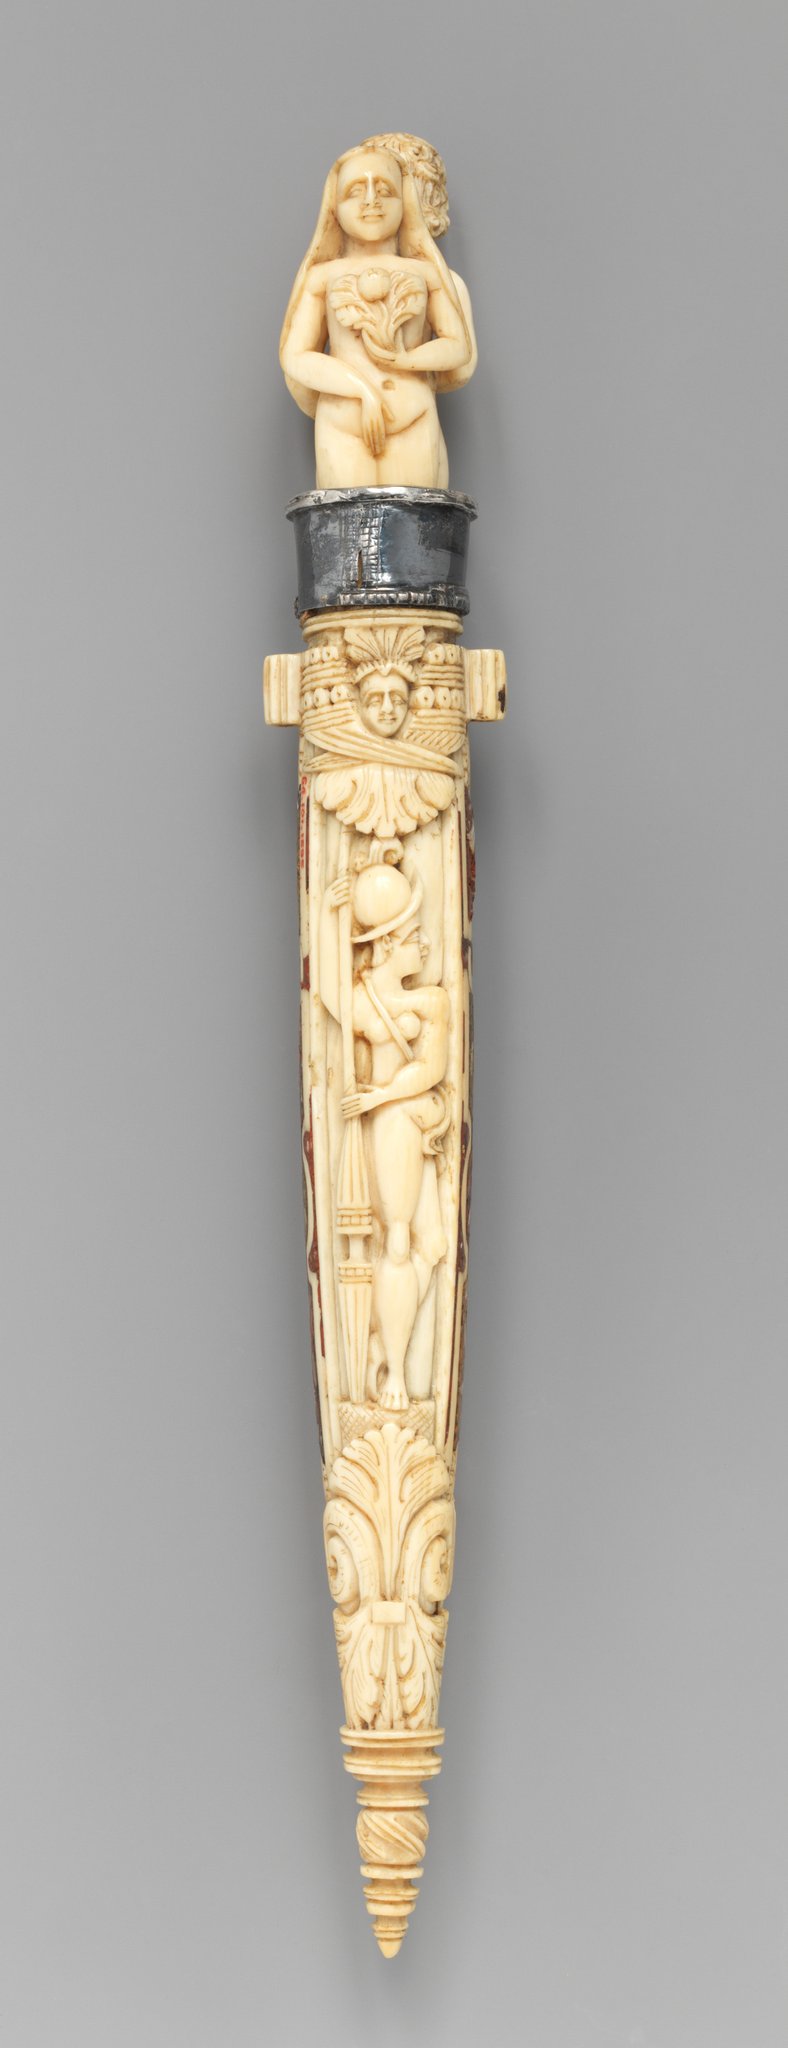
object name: wedding knife, fork and sheath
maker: ephraim how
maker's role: maker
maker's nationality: british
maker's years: 1652-1720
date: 1651-1675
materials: ivory, silver, steel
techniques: inlay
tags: male nudes,female nudes